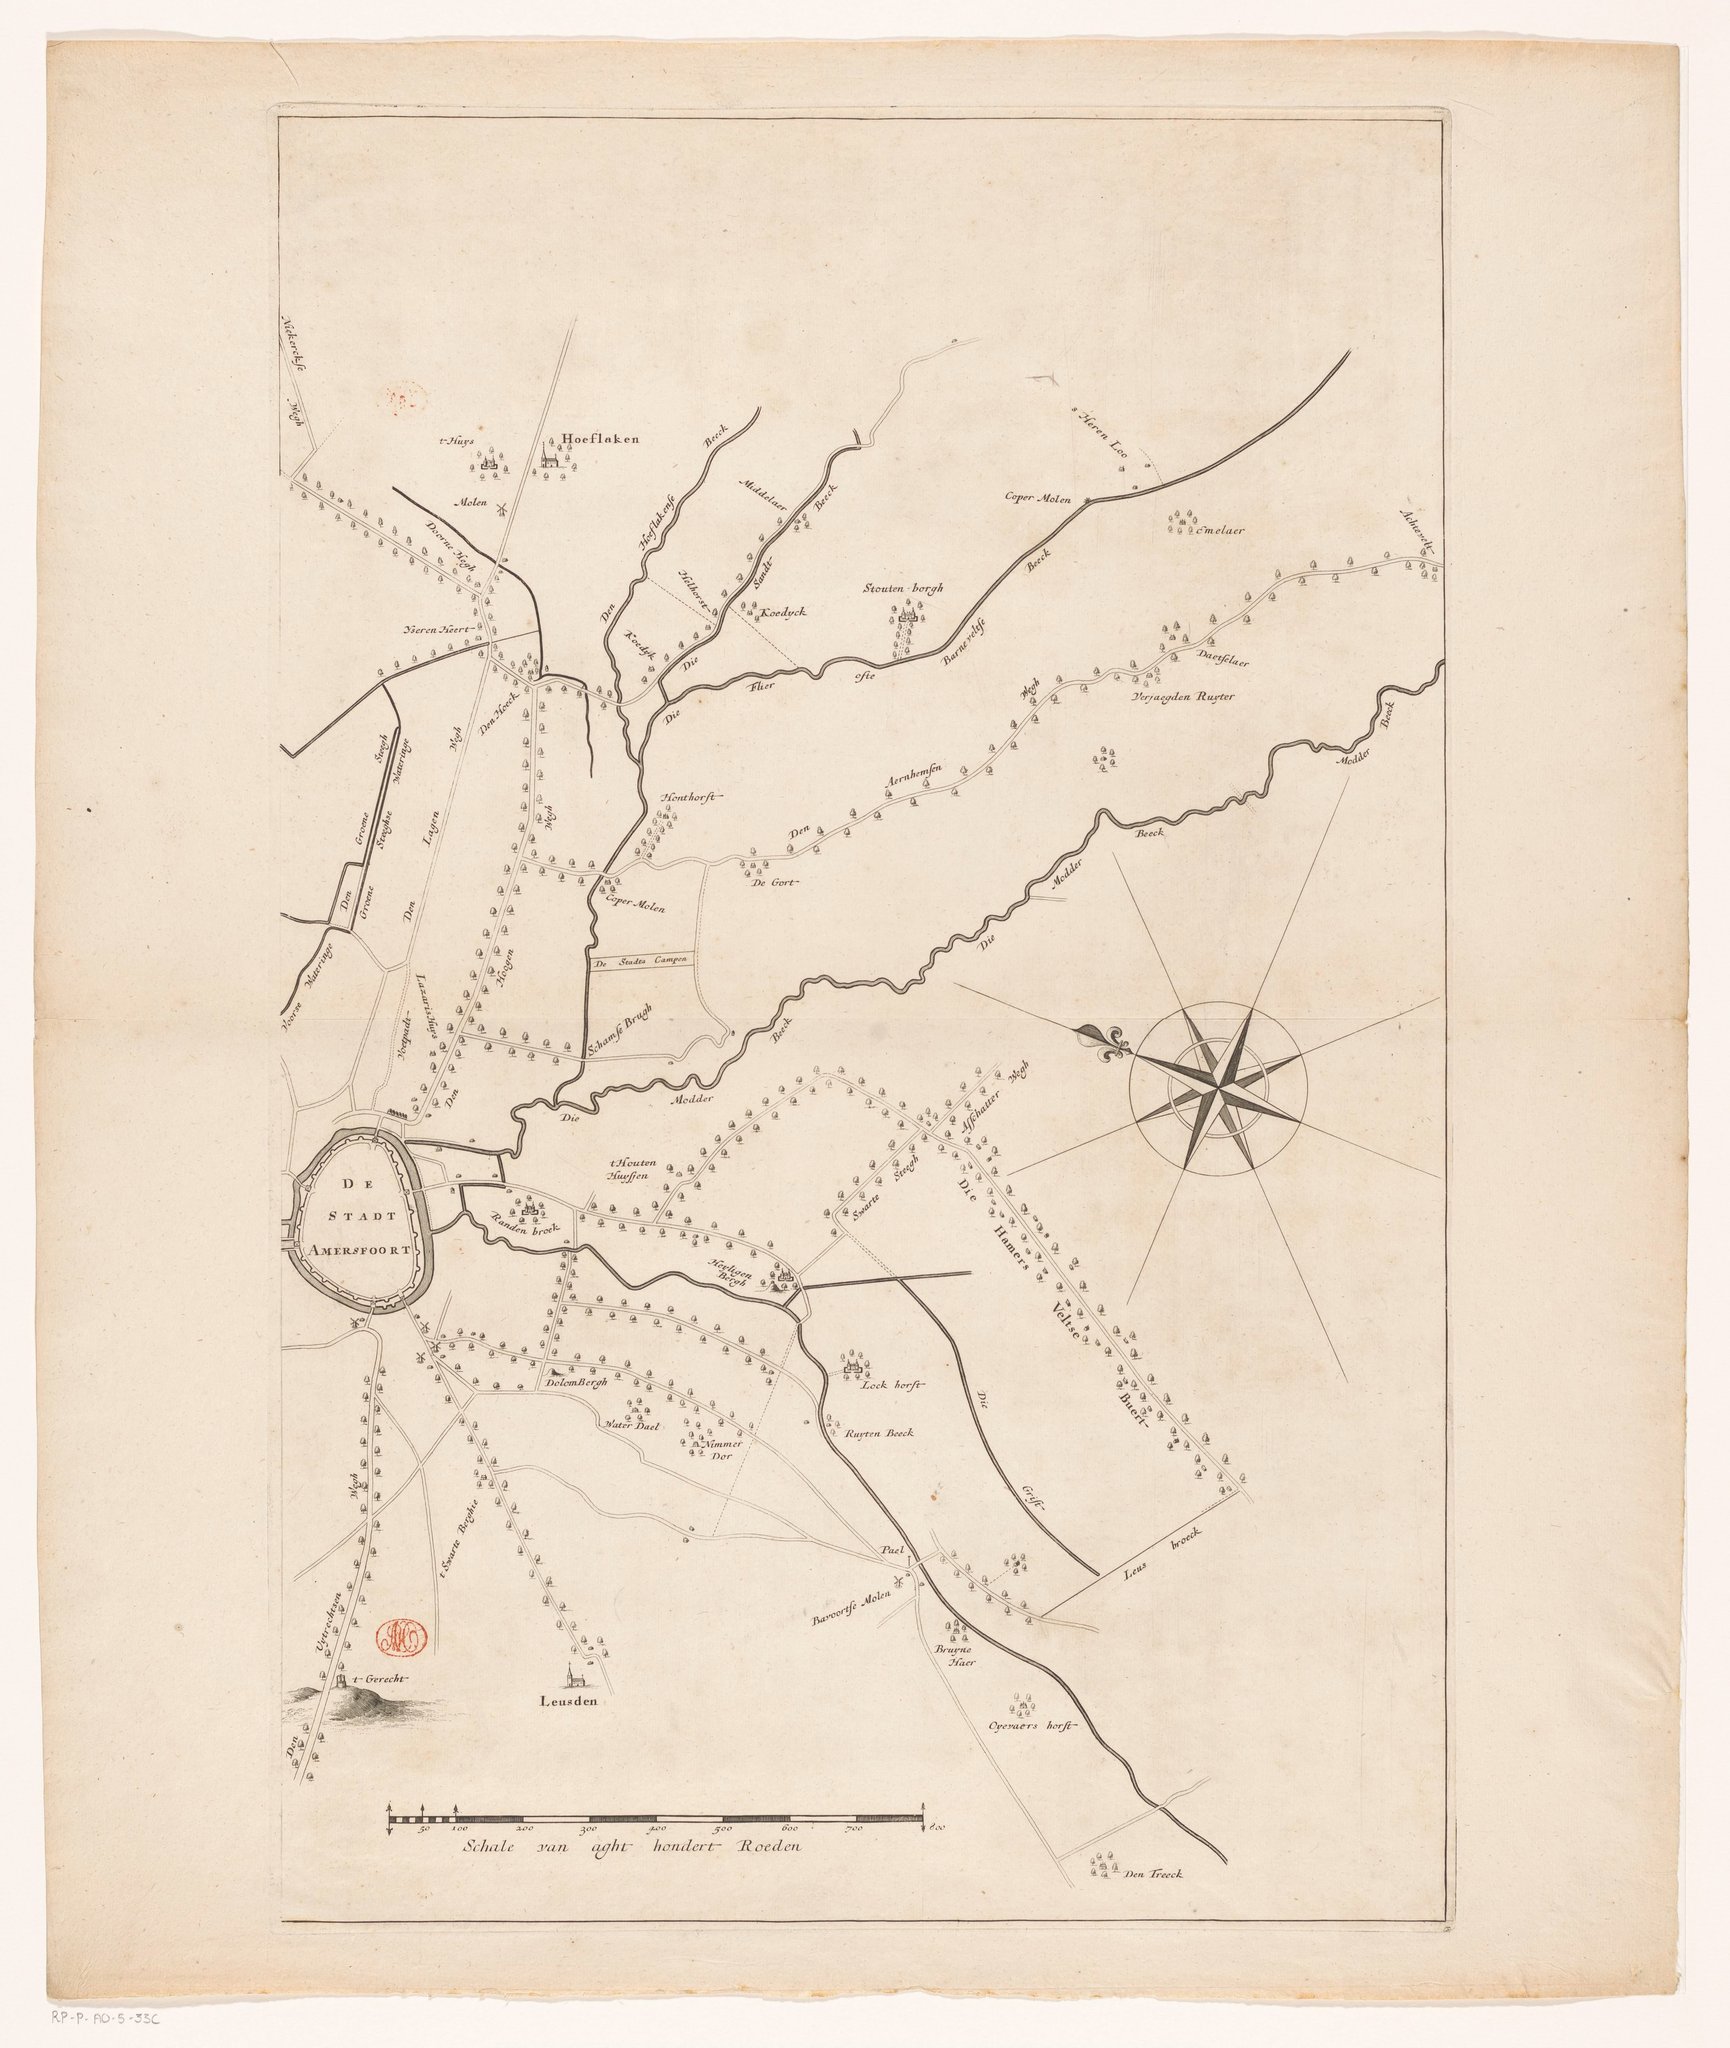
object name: map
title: Kaart van de rivier de Eem (derde deel)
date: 1692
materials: paper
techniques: engraving, etching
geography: utrecht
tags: maps of separate countries or regions, river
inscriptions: collector's mark: Lugt 195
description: In tegenstelling tot latere beschreven staten komen de namen van de genoemde leden van het College van Watergraaf en Heemraden in de cartouche linksonder overeen met de afgebeelde namen en wapens op de kaart. Hiermee kan het huidige exemplaar gedateerd worden volgens de datering op de kaart: 1692, toen de genoemde personen lid waren van het College.